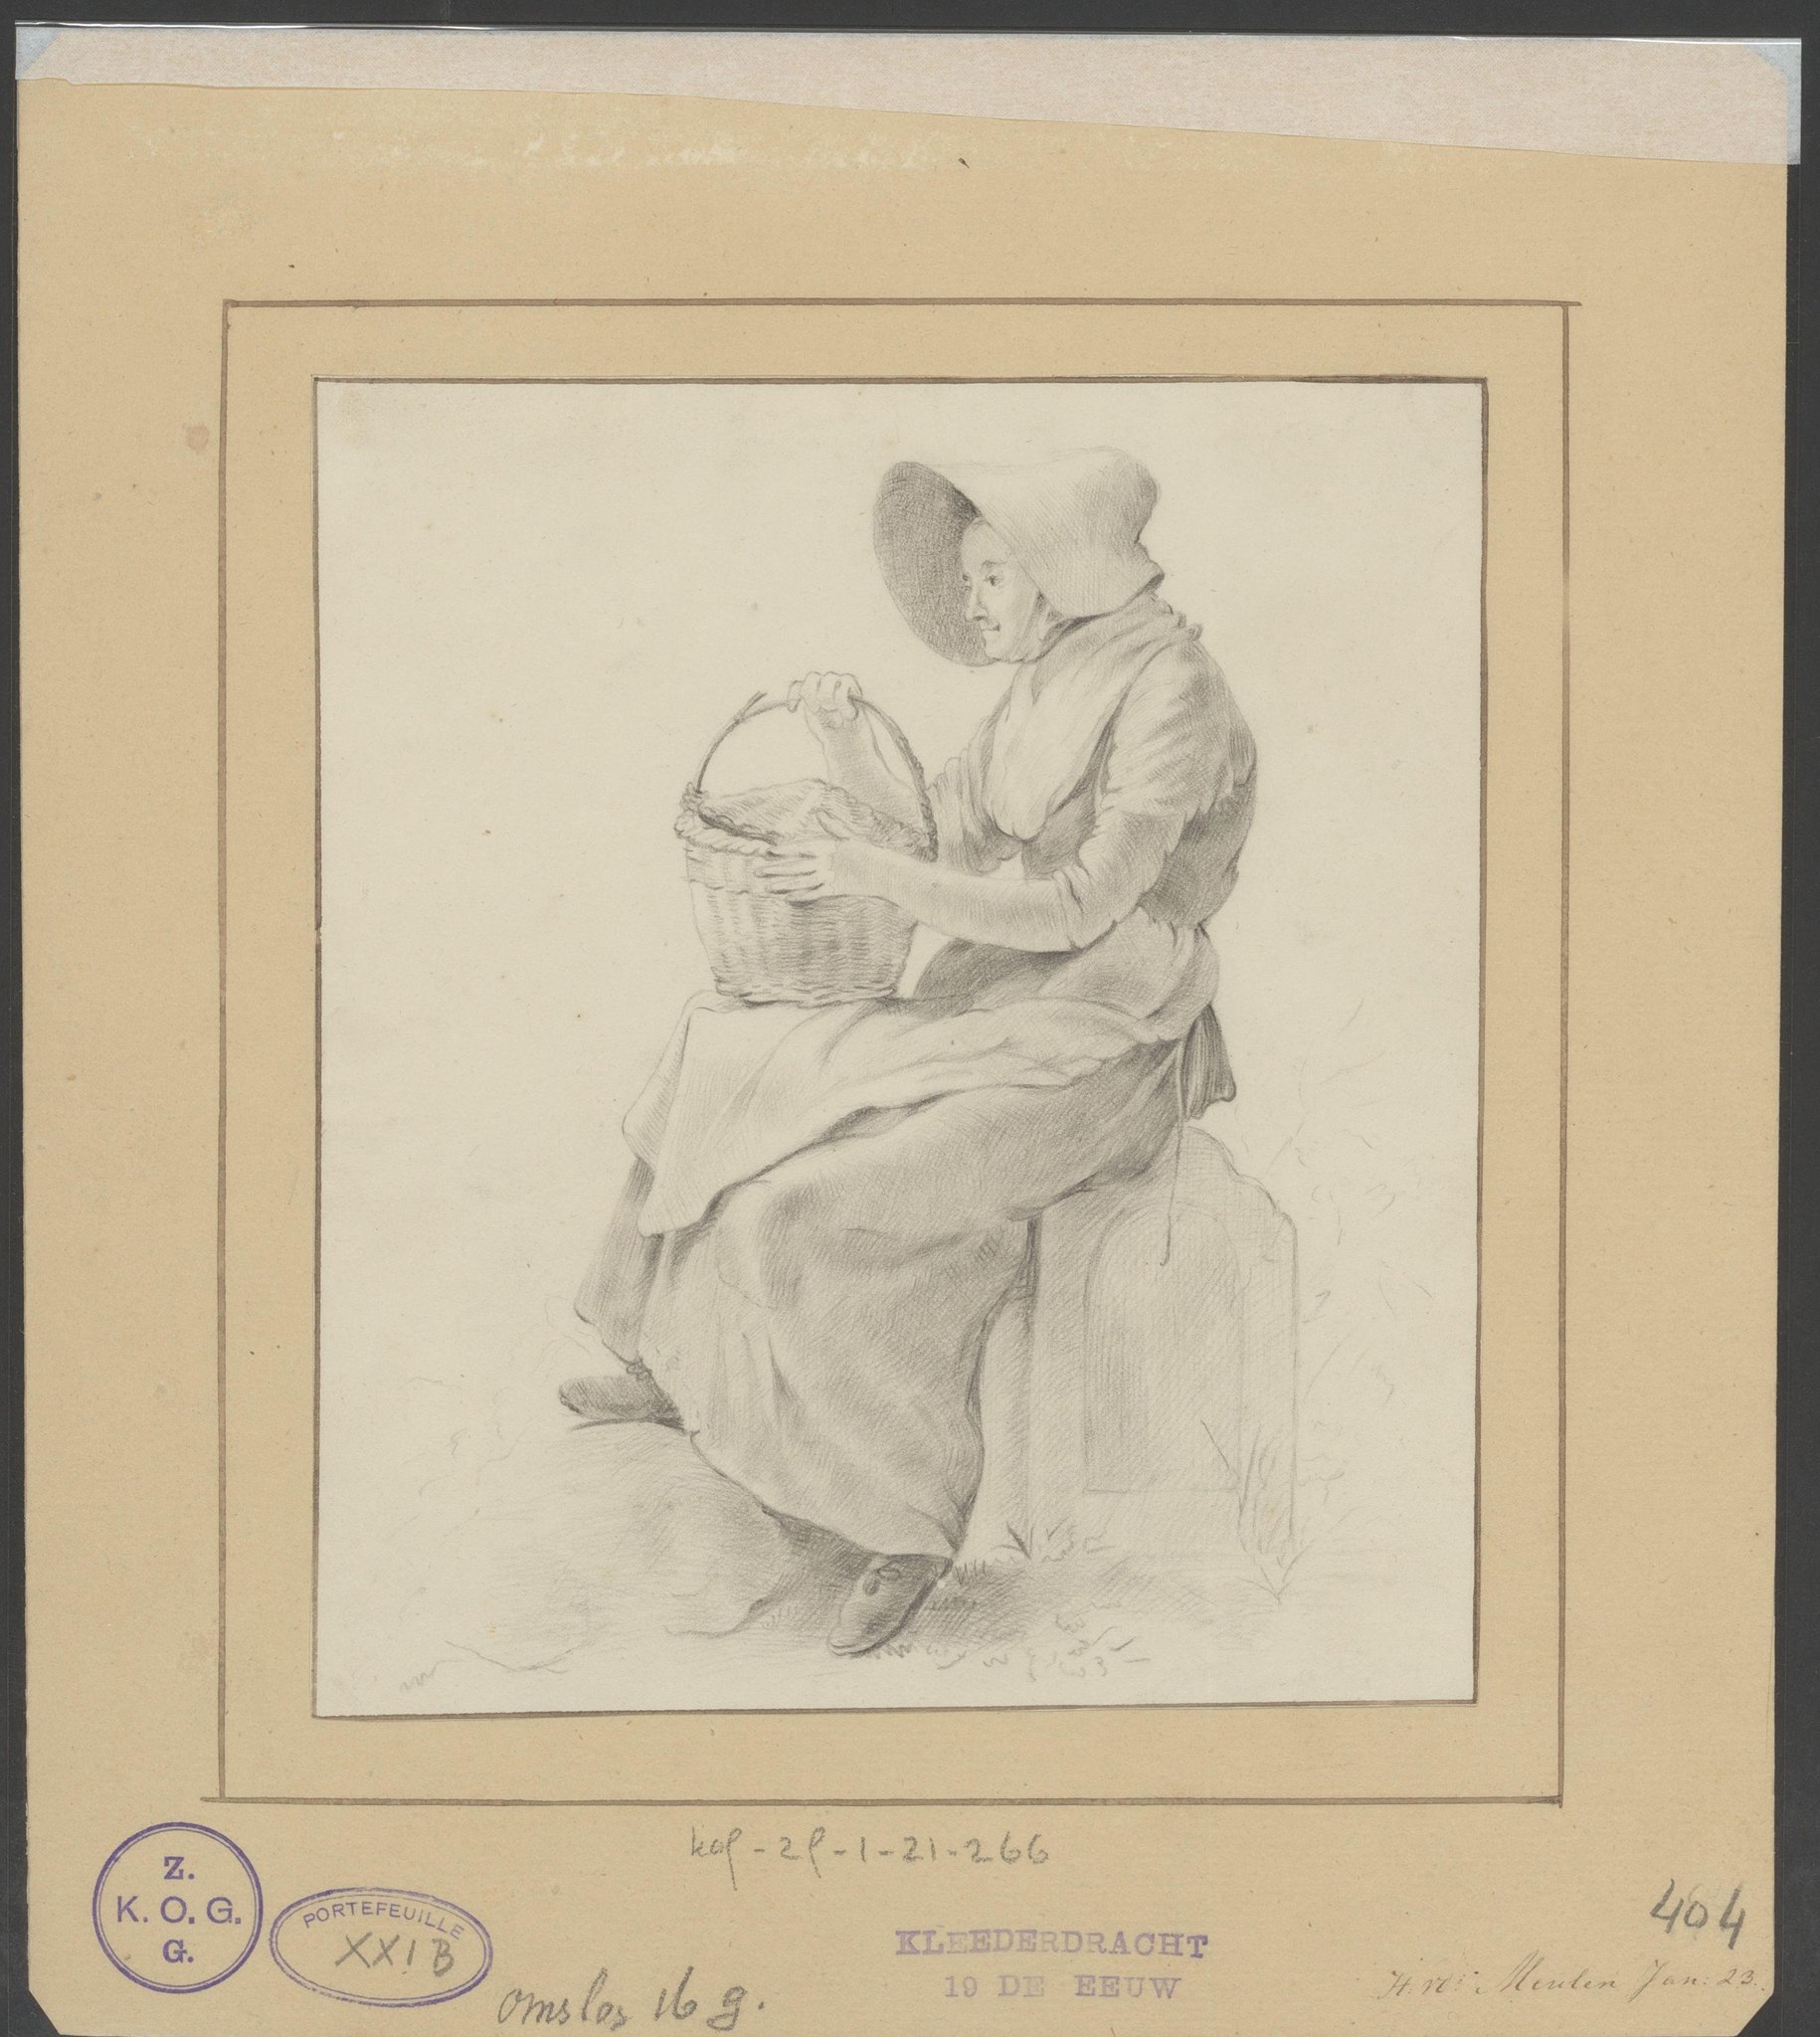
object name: drawing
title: Zittende vrouw met een mand op haar schoot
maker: Anonymous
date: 1800-1849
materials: paper, pencil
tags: container made of plant material other than wood: basket, head-gear: hat, sitting on an elevation - aa - female human figure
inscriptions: stamp, stamp, collector's mark: Lugt 1641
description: Onderwerpsrubrieken binnen de Atlas Zeden en Gewoonten: Zeden en Gewoonten in Engeren Zin, De Kleeding, Kleederdrachten (tijdvakken), De regeering van Willem I. Mannen en vrouwen.